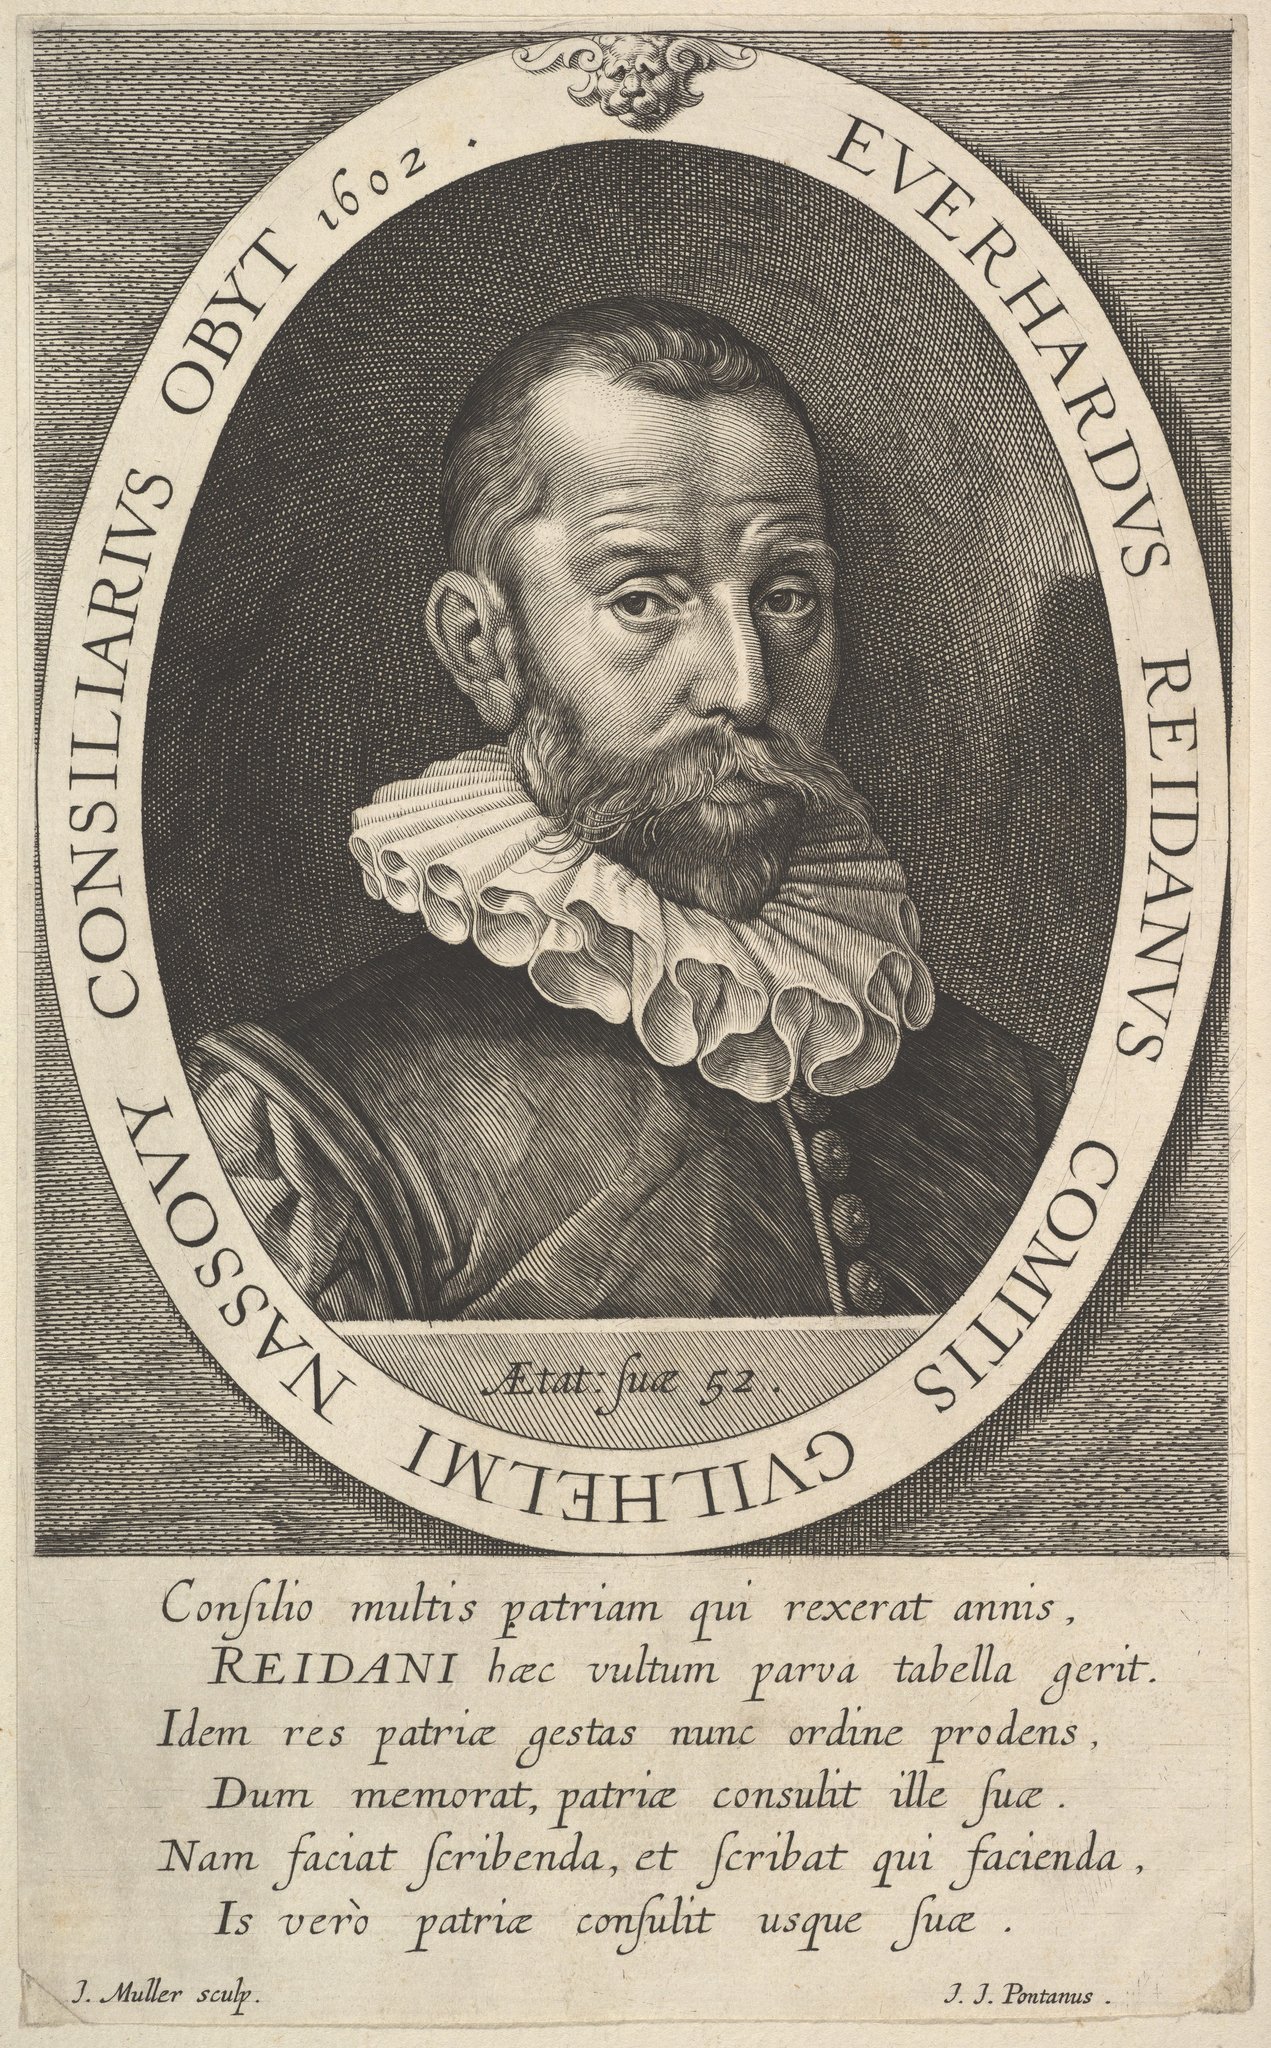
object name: print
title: Portrait of Everhard van Reyd, Councillor of William, Prince of Orange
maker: jan muller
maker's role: artist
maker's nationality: netherlandish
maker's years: 1571-1628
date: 1602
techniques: engraving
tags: men,portraits